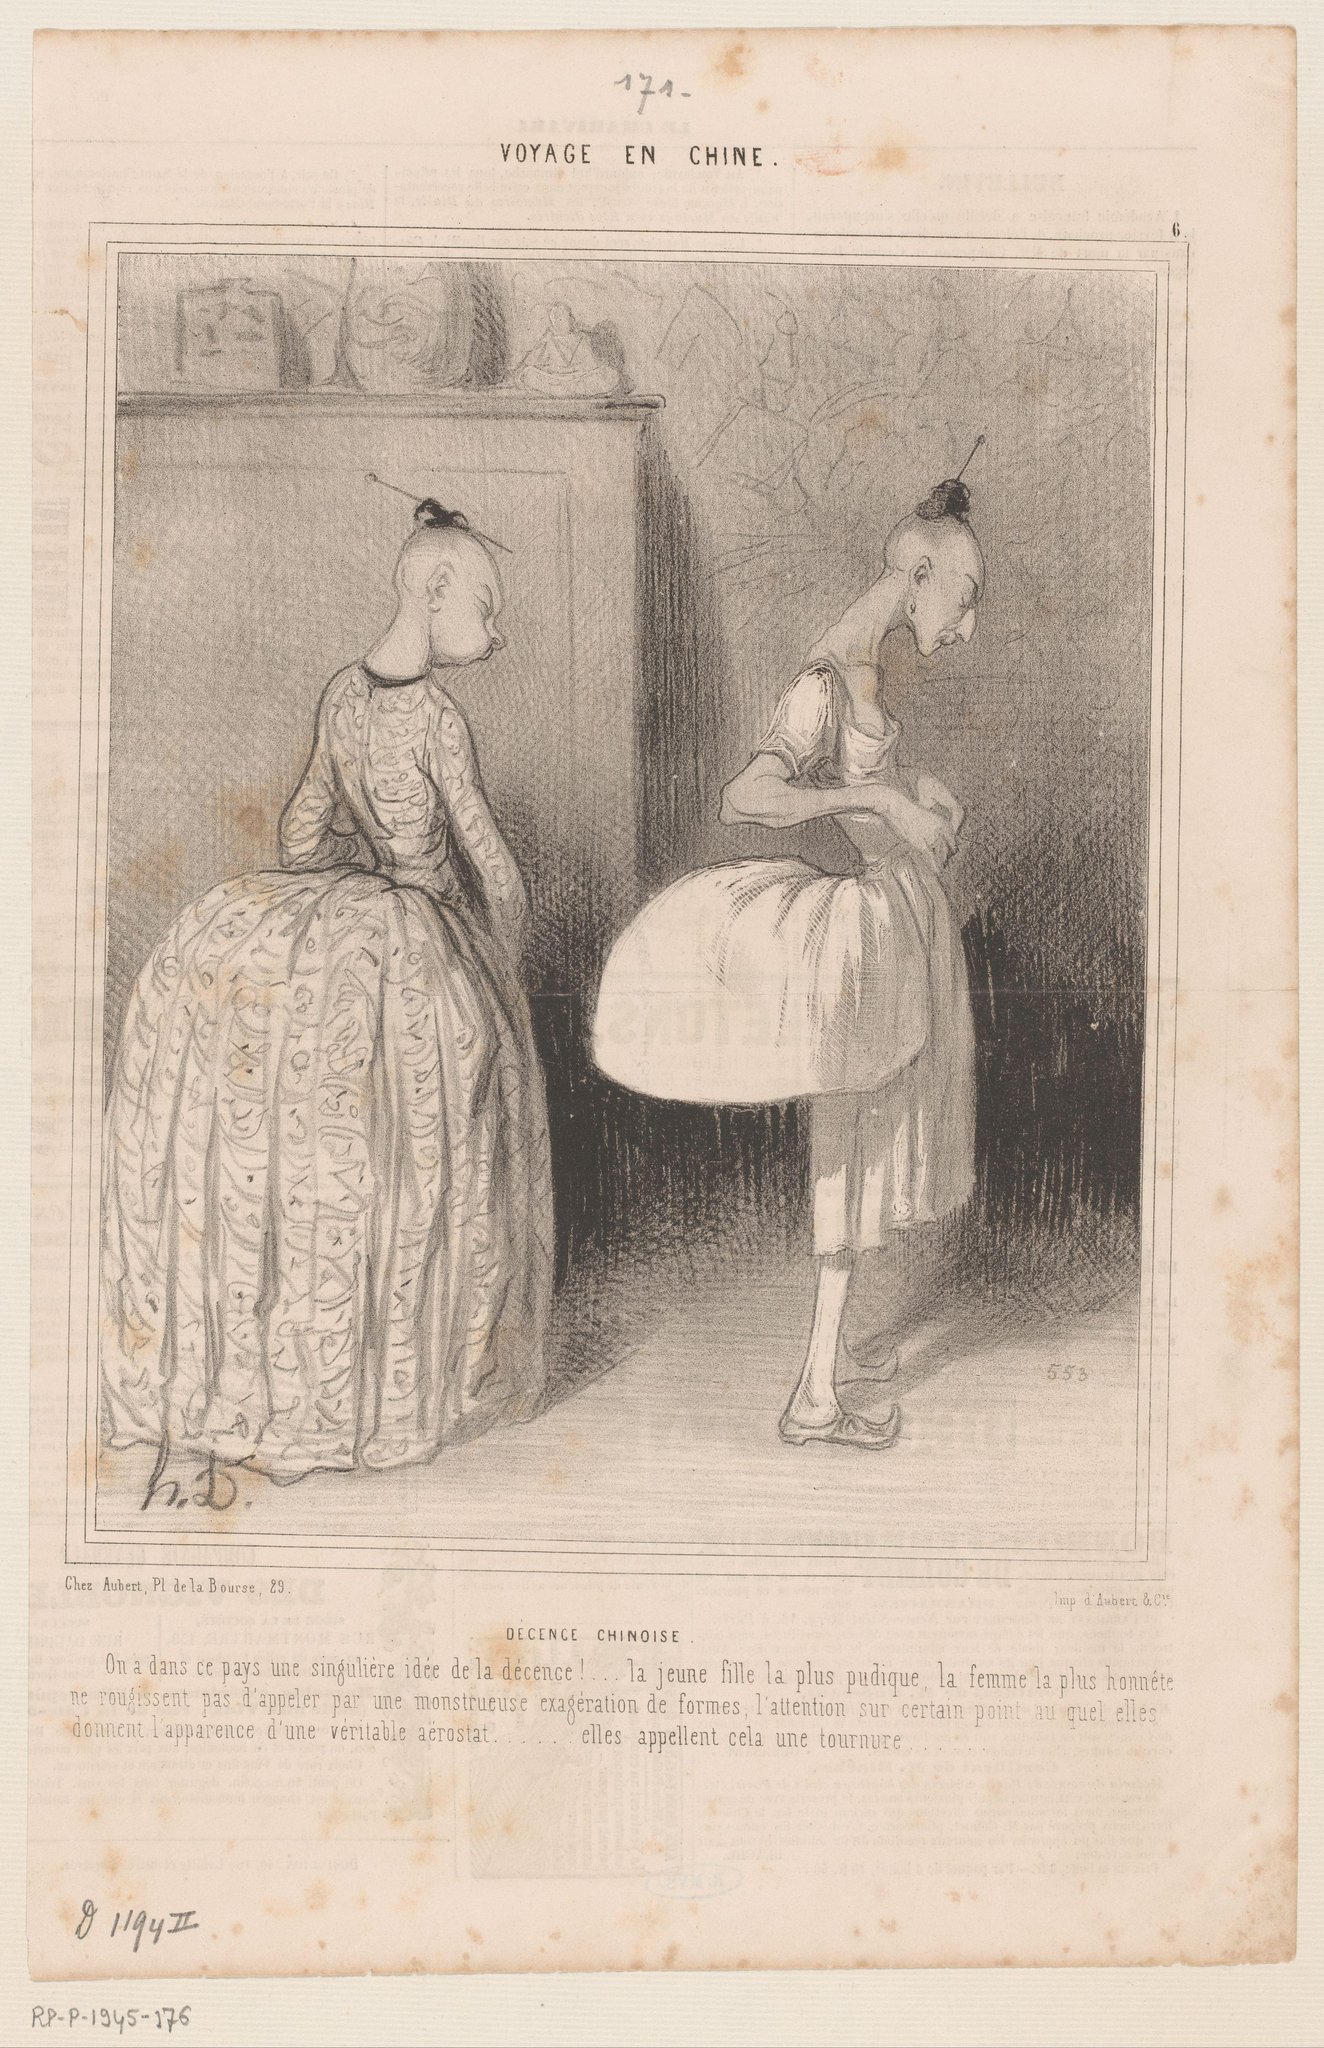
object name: print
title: Twee Chinese vrouwen in Franse jurken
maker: honoré daumier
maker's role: draughtsman, painter, print maker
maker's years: 1808-1879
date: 1844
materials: paper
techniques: lithograph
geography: paris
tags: caricatures (human types), underclothes, chinese (+ caricatured), dressing oneself, getting dressed - aa - female human figure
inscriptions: collector's mark: Lugt 2228a, number: ‘171’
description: Rechts past een Chinese vrouw een Franse tournure; een onderrok die aan de achterkant veel volume geeft. De vrouwen mopperen dat de vormen van de Franse mode niet bescheiden zijn.